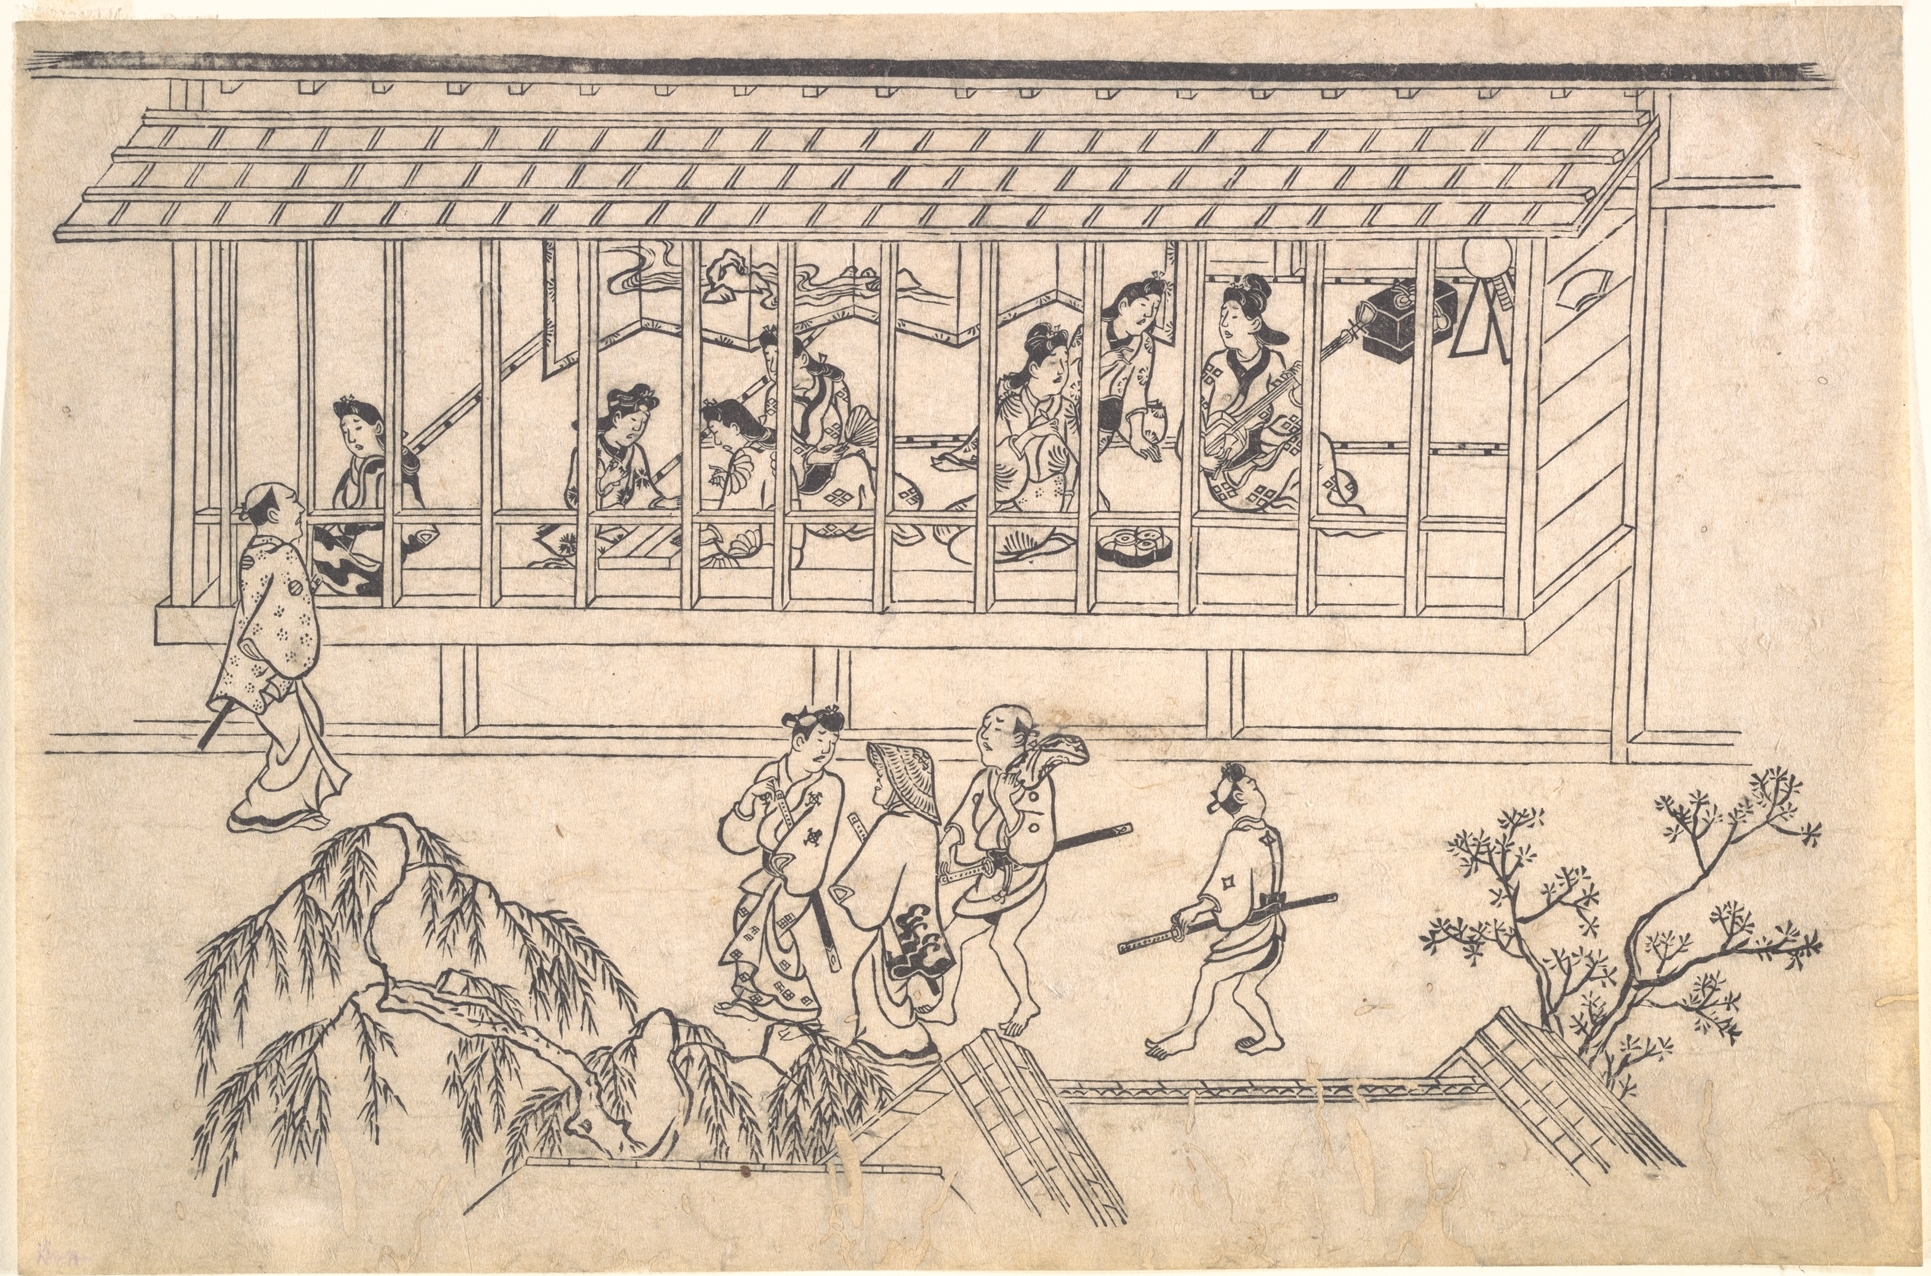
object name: print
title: The Sixth Scene from Scenes of the Pleasure Quarter at Yoshiwara in Edo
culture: japanese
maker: hishikawa moronobu 菱川師宣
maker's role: artist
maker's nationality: japanese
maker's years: 1618-1694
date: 1667-1700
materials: ink, paper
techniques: woodblock print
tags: men,women,trees